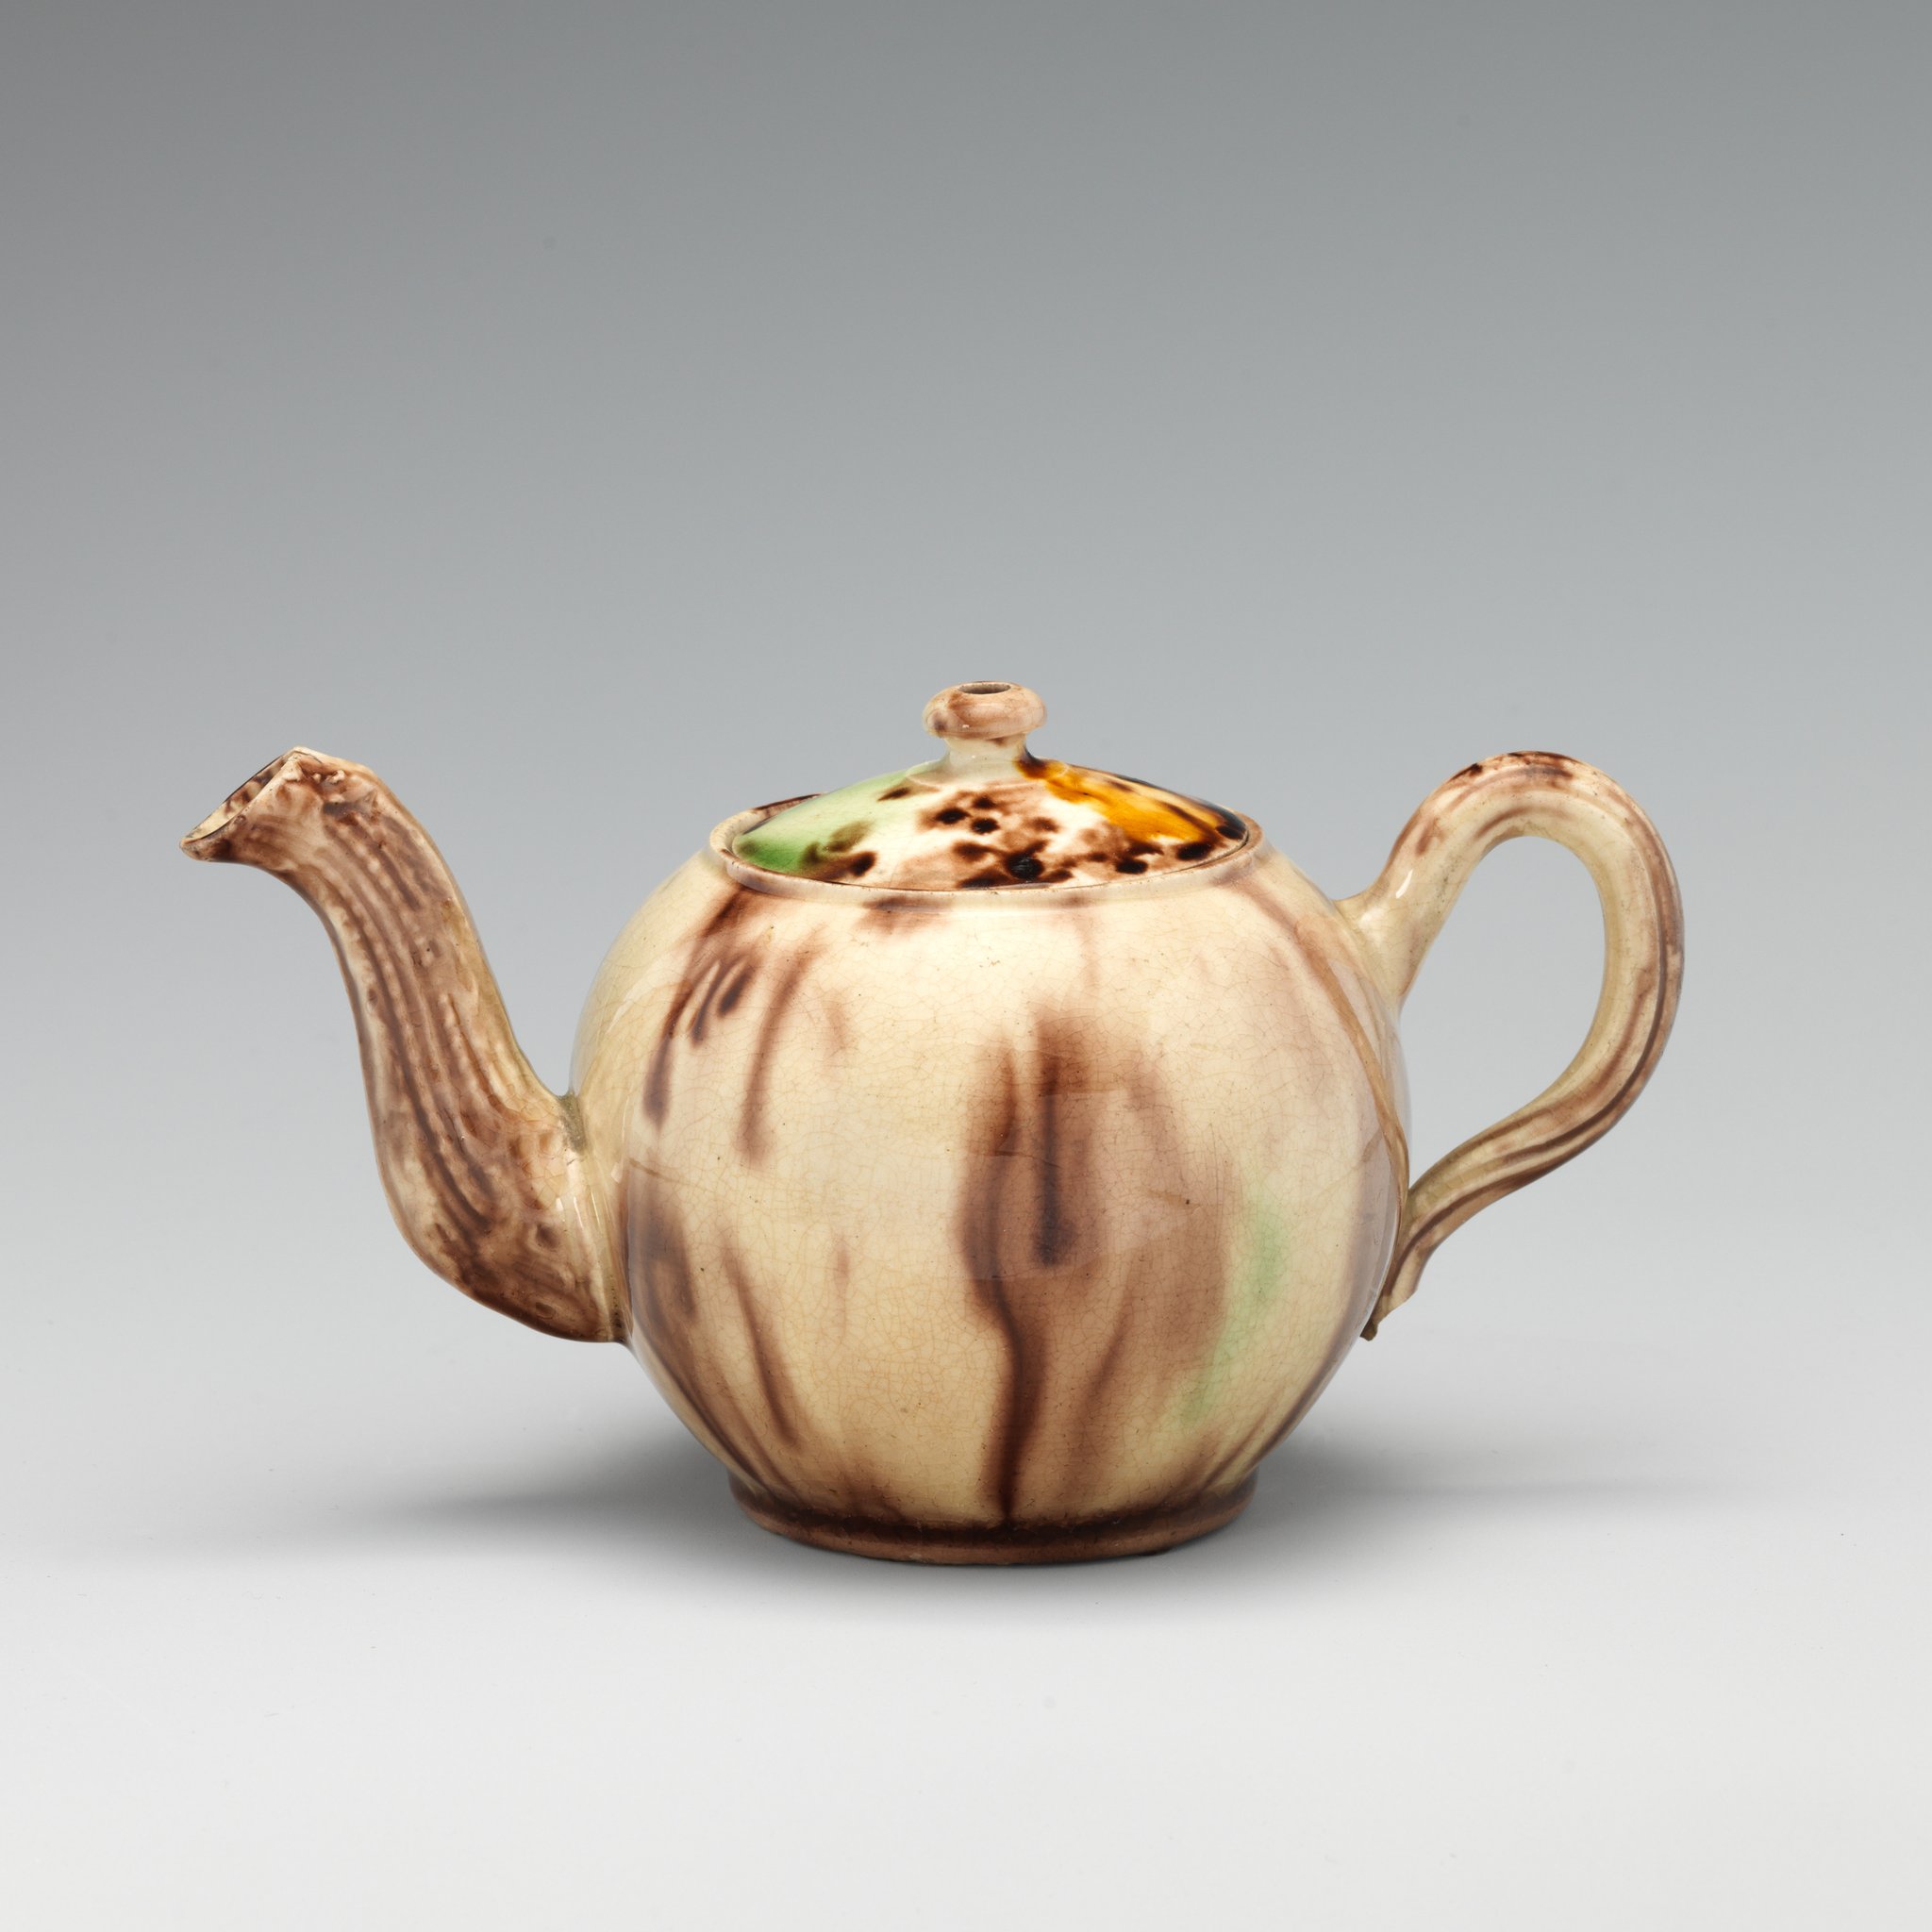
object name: teapot with cover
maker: whieldon type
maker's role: maker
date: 1734-1766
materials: earthenware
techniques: glazing